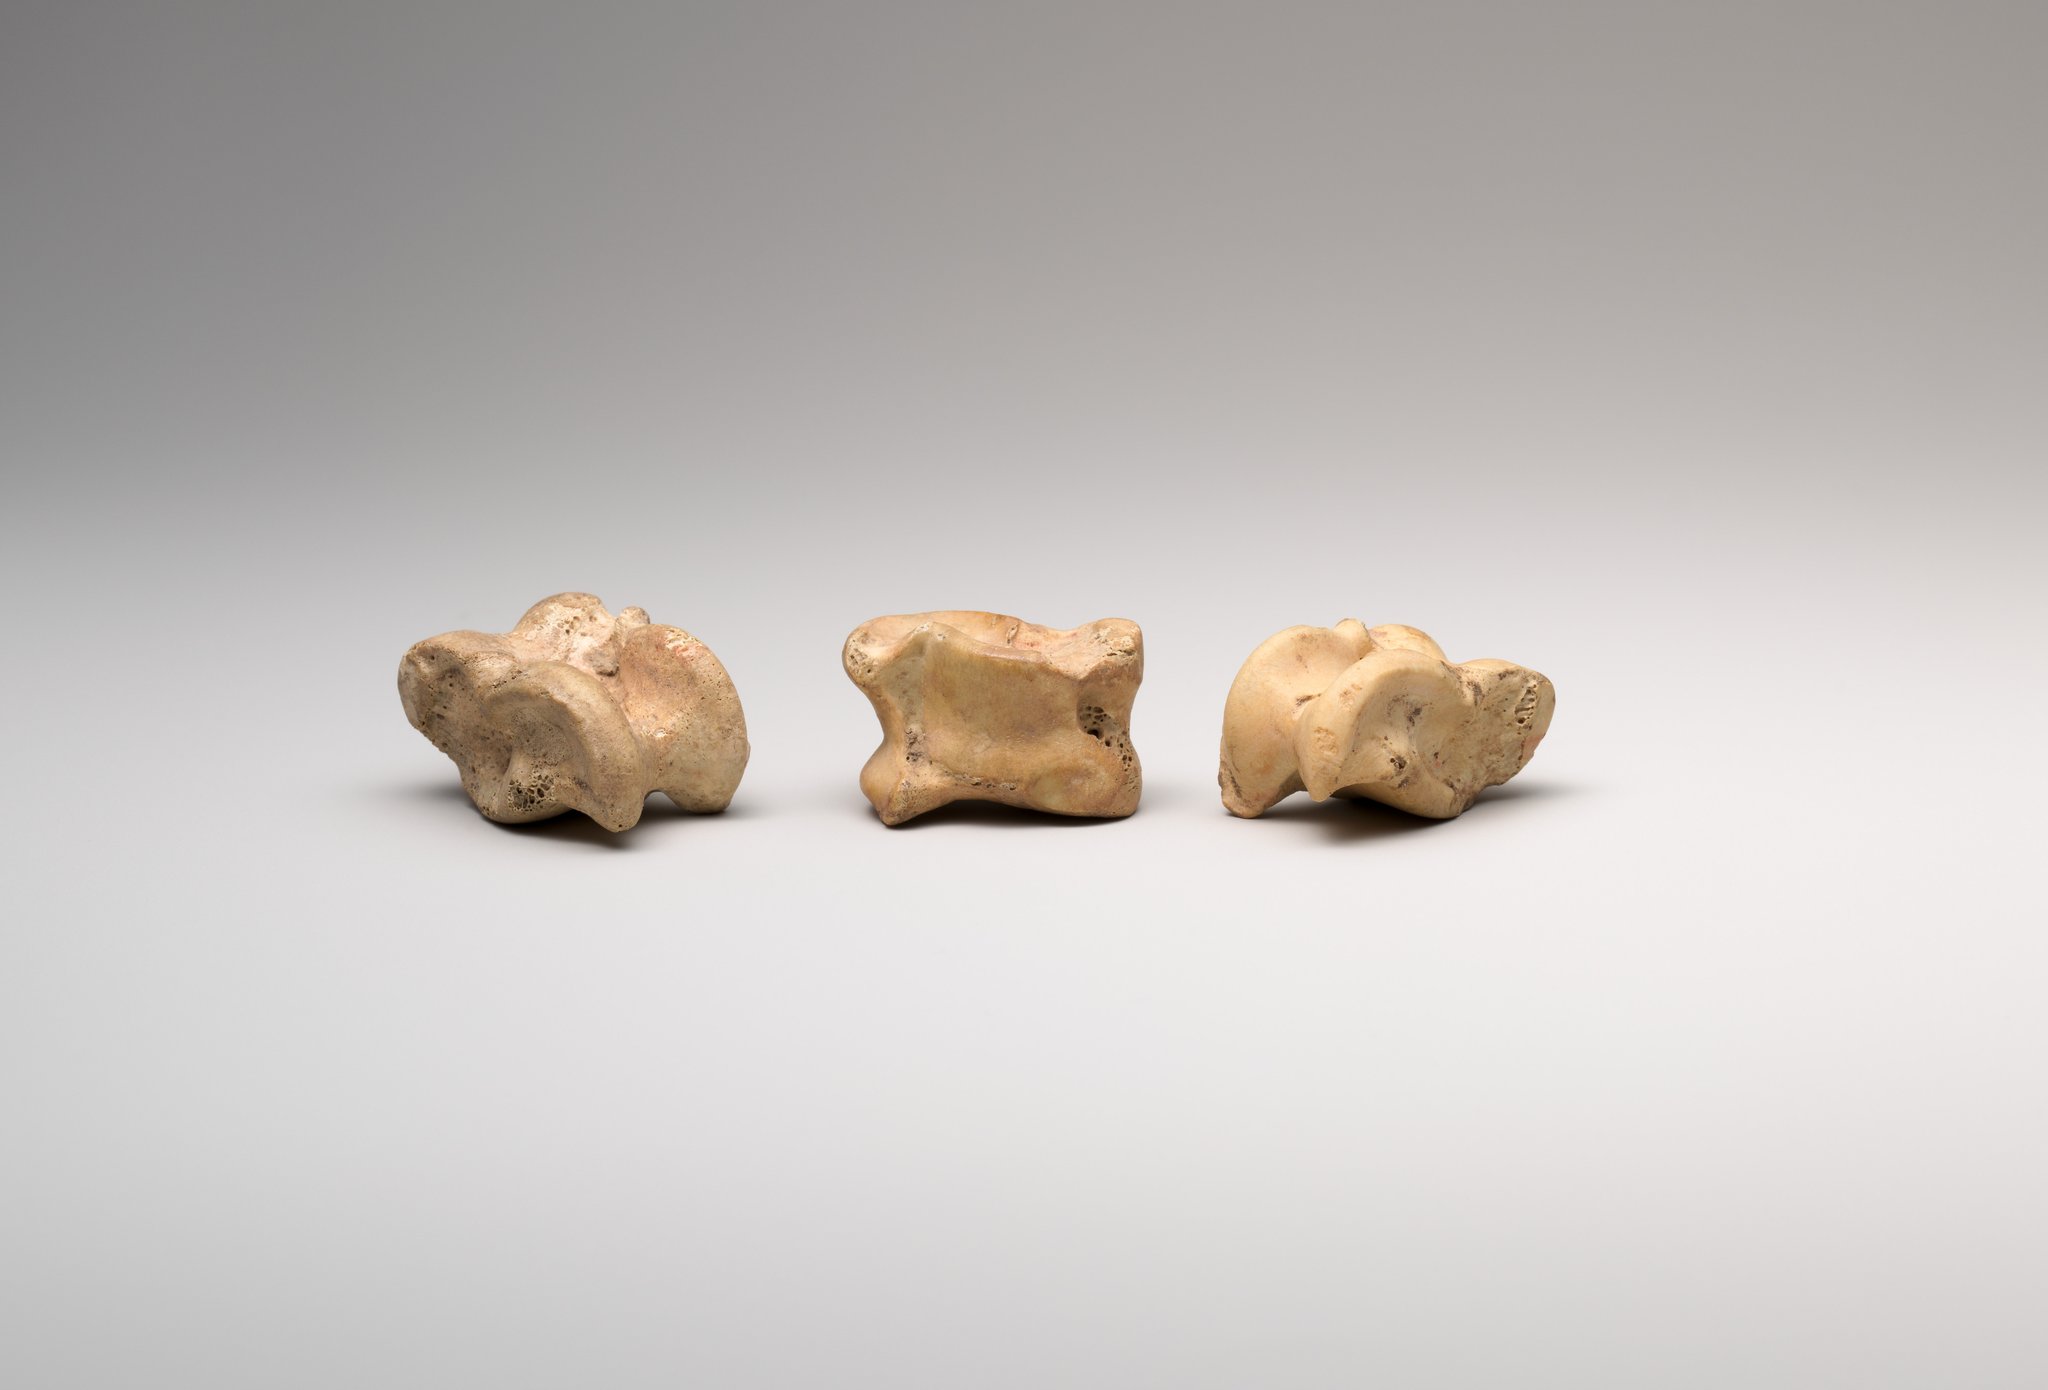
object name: game counter, knuckle bone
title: Three Knuckle bone Gaming Pieces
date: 1550-1458 BCE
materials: bone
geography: egypt